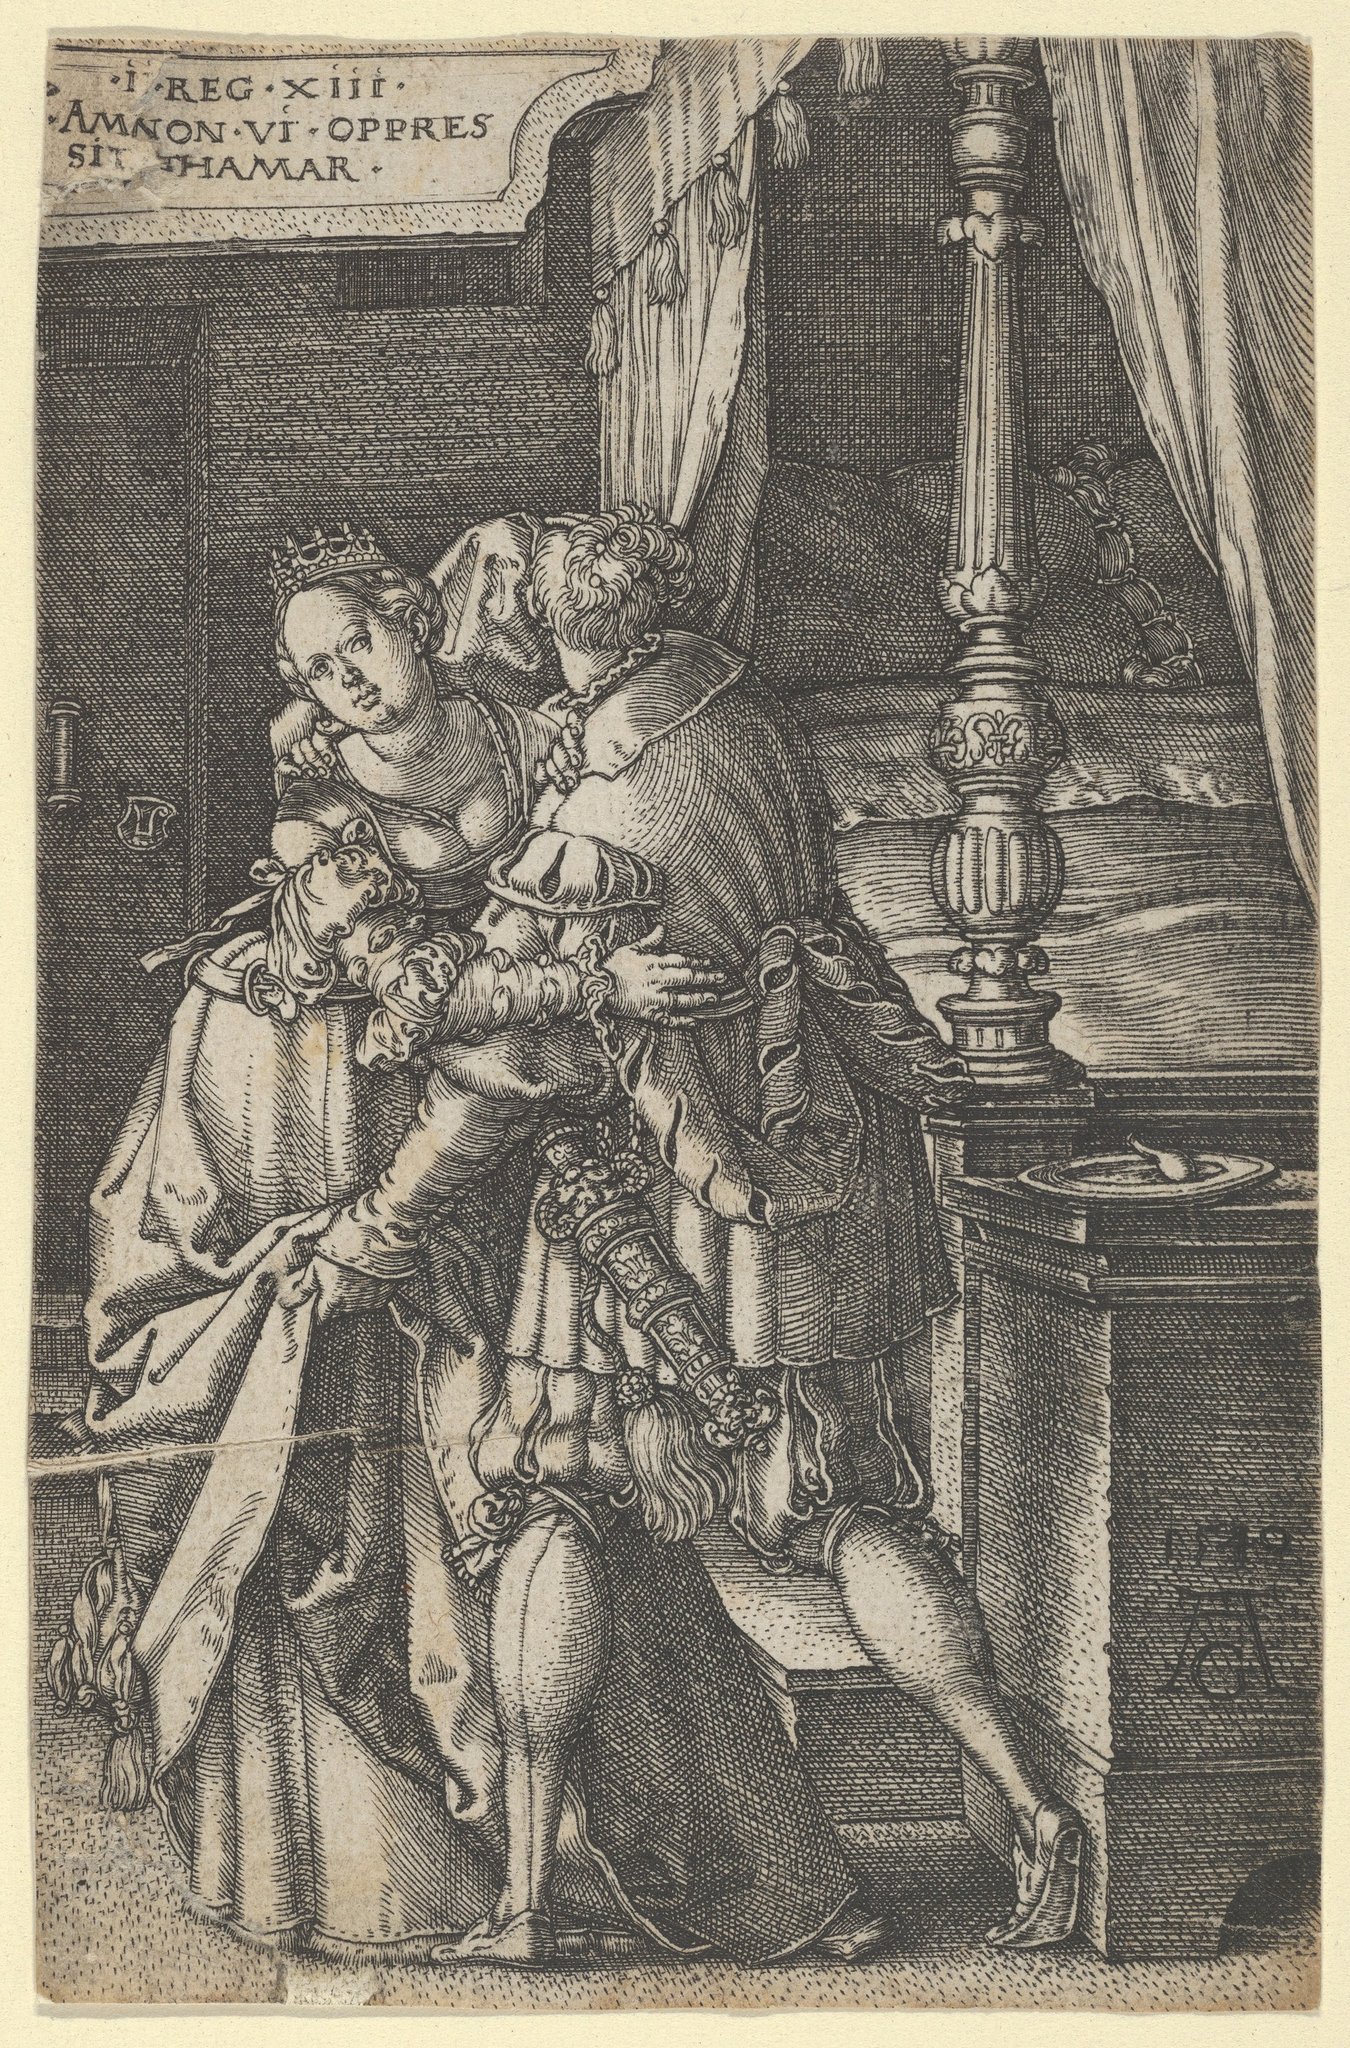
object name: print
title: Amnon Violating Tamar, from "The Story of Amnon and Tamar"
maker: heinrich aldegrever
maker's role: artist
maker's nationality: german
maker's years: 1502-1561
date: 1540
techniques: engraving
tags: men,women,beds